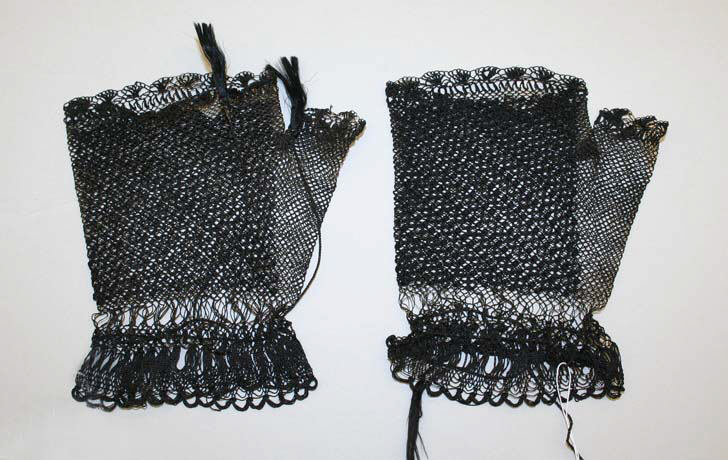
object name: mitt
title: Mitts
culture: american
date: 1801-1833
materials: silk